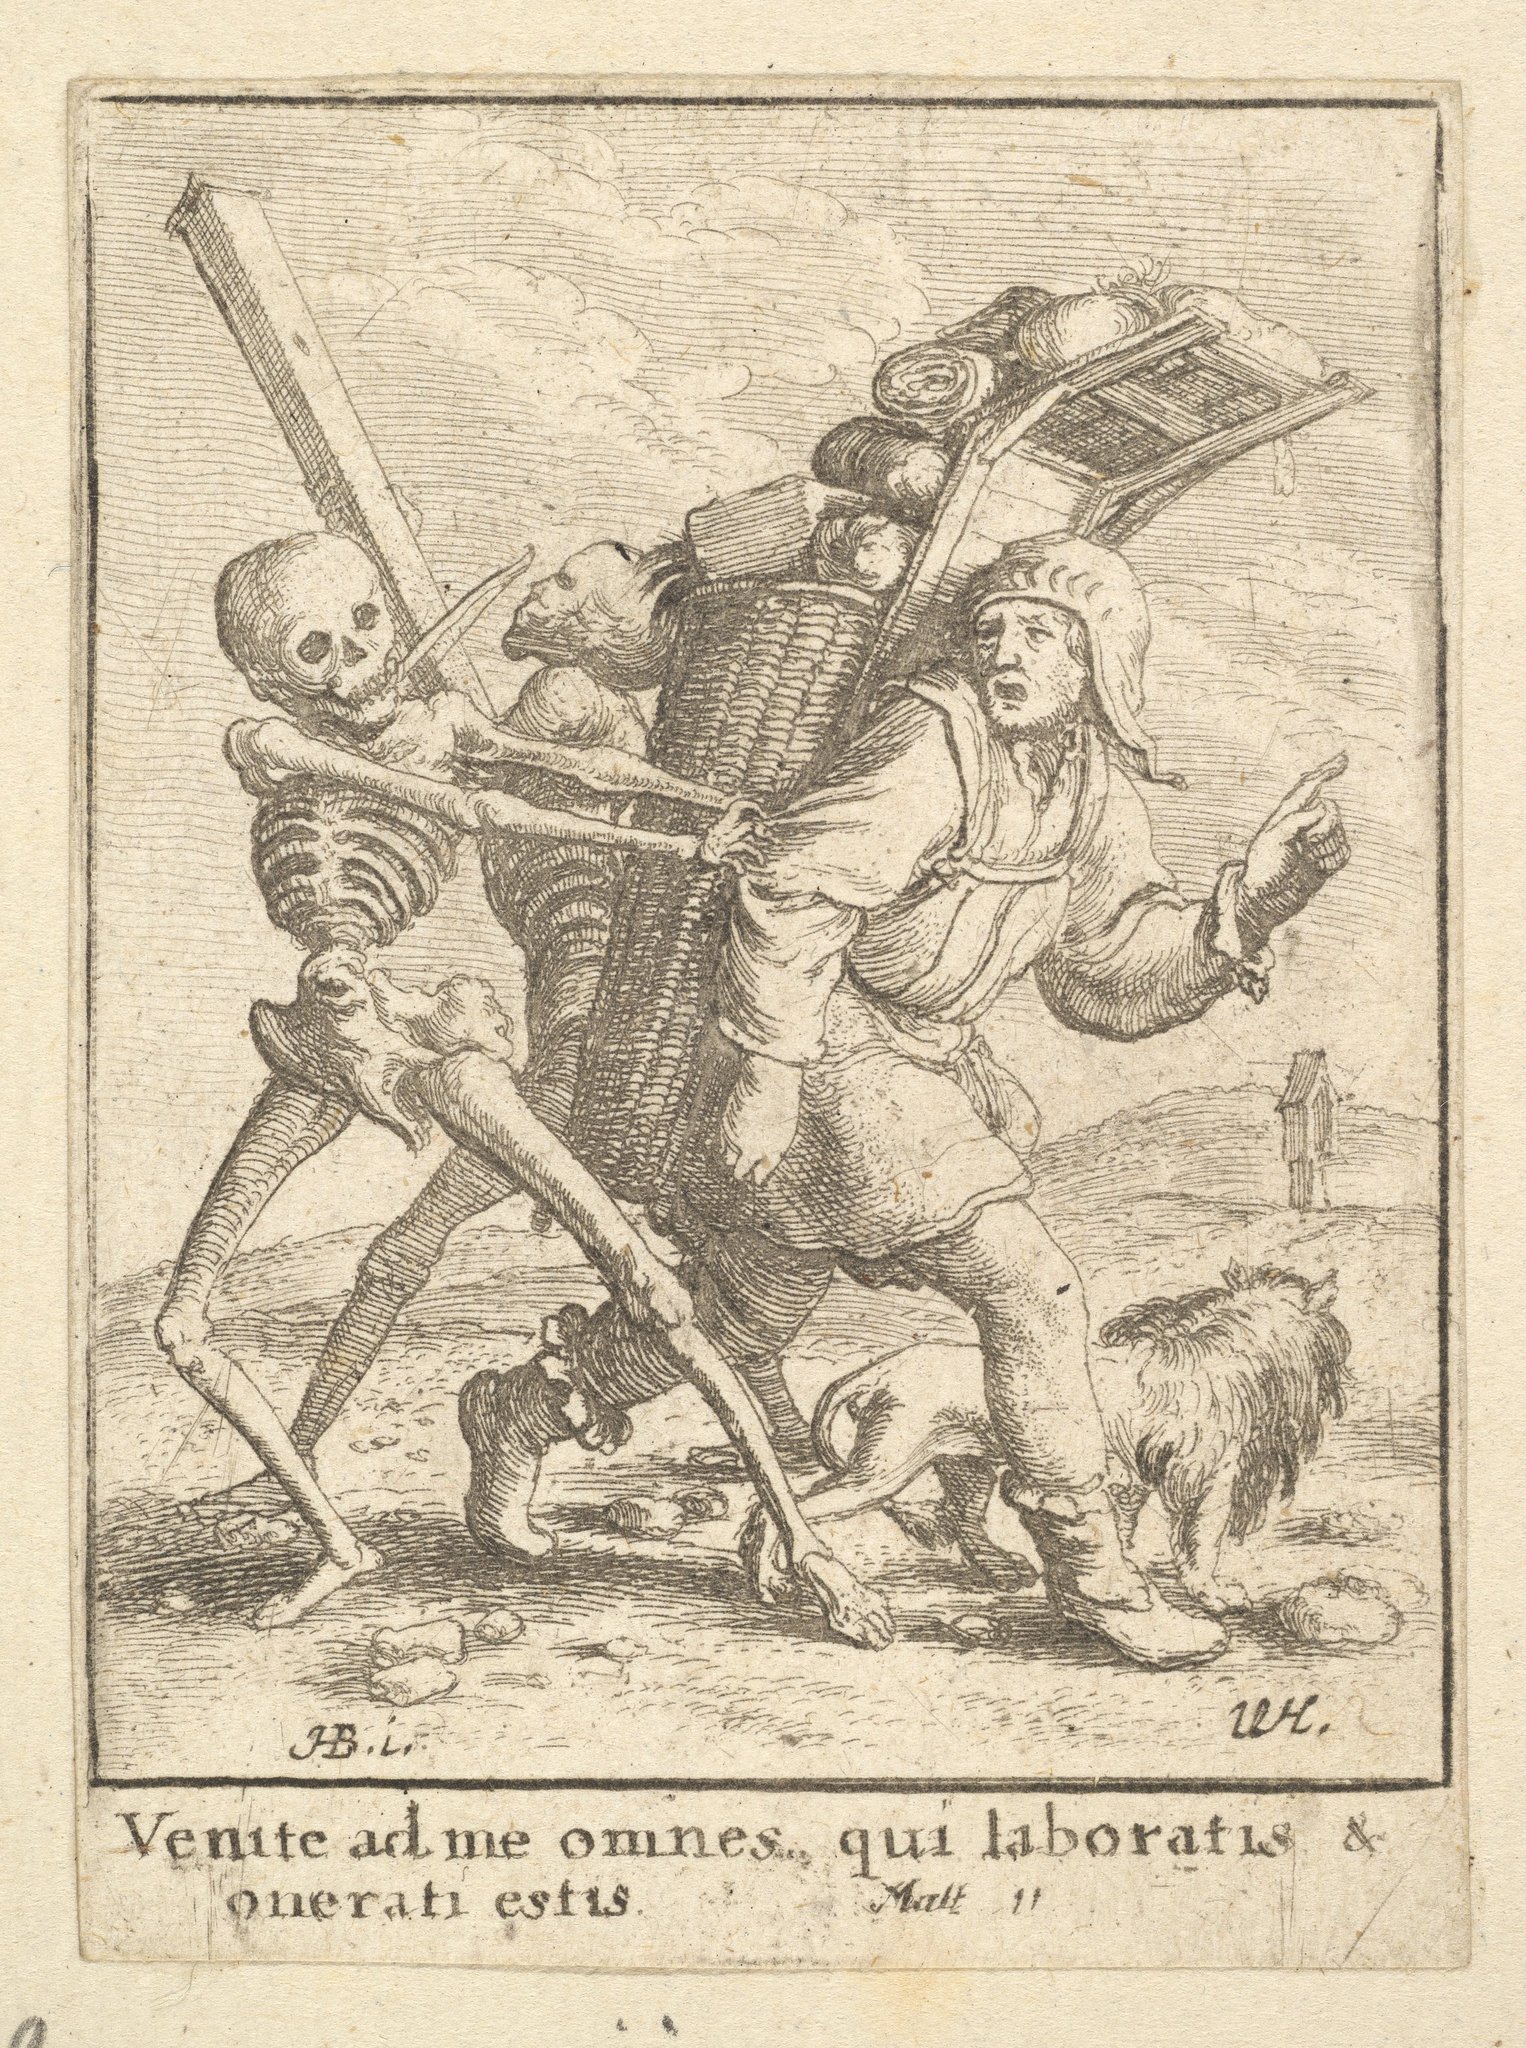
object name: print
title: The Pedlar, from the Dance of Death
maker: wenceslaus hollar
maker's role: artist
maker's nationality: bohemian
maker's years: 1607-1677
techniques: etching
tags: skeletons,men,lions